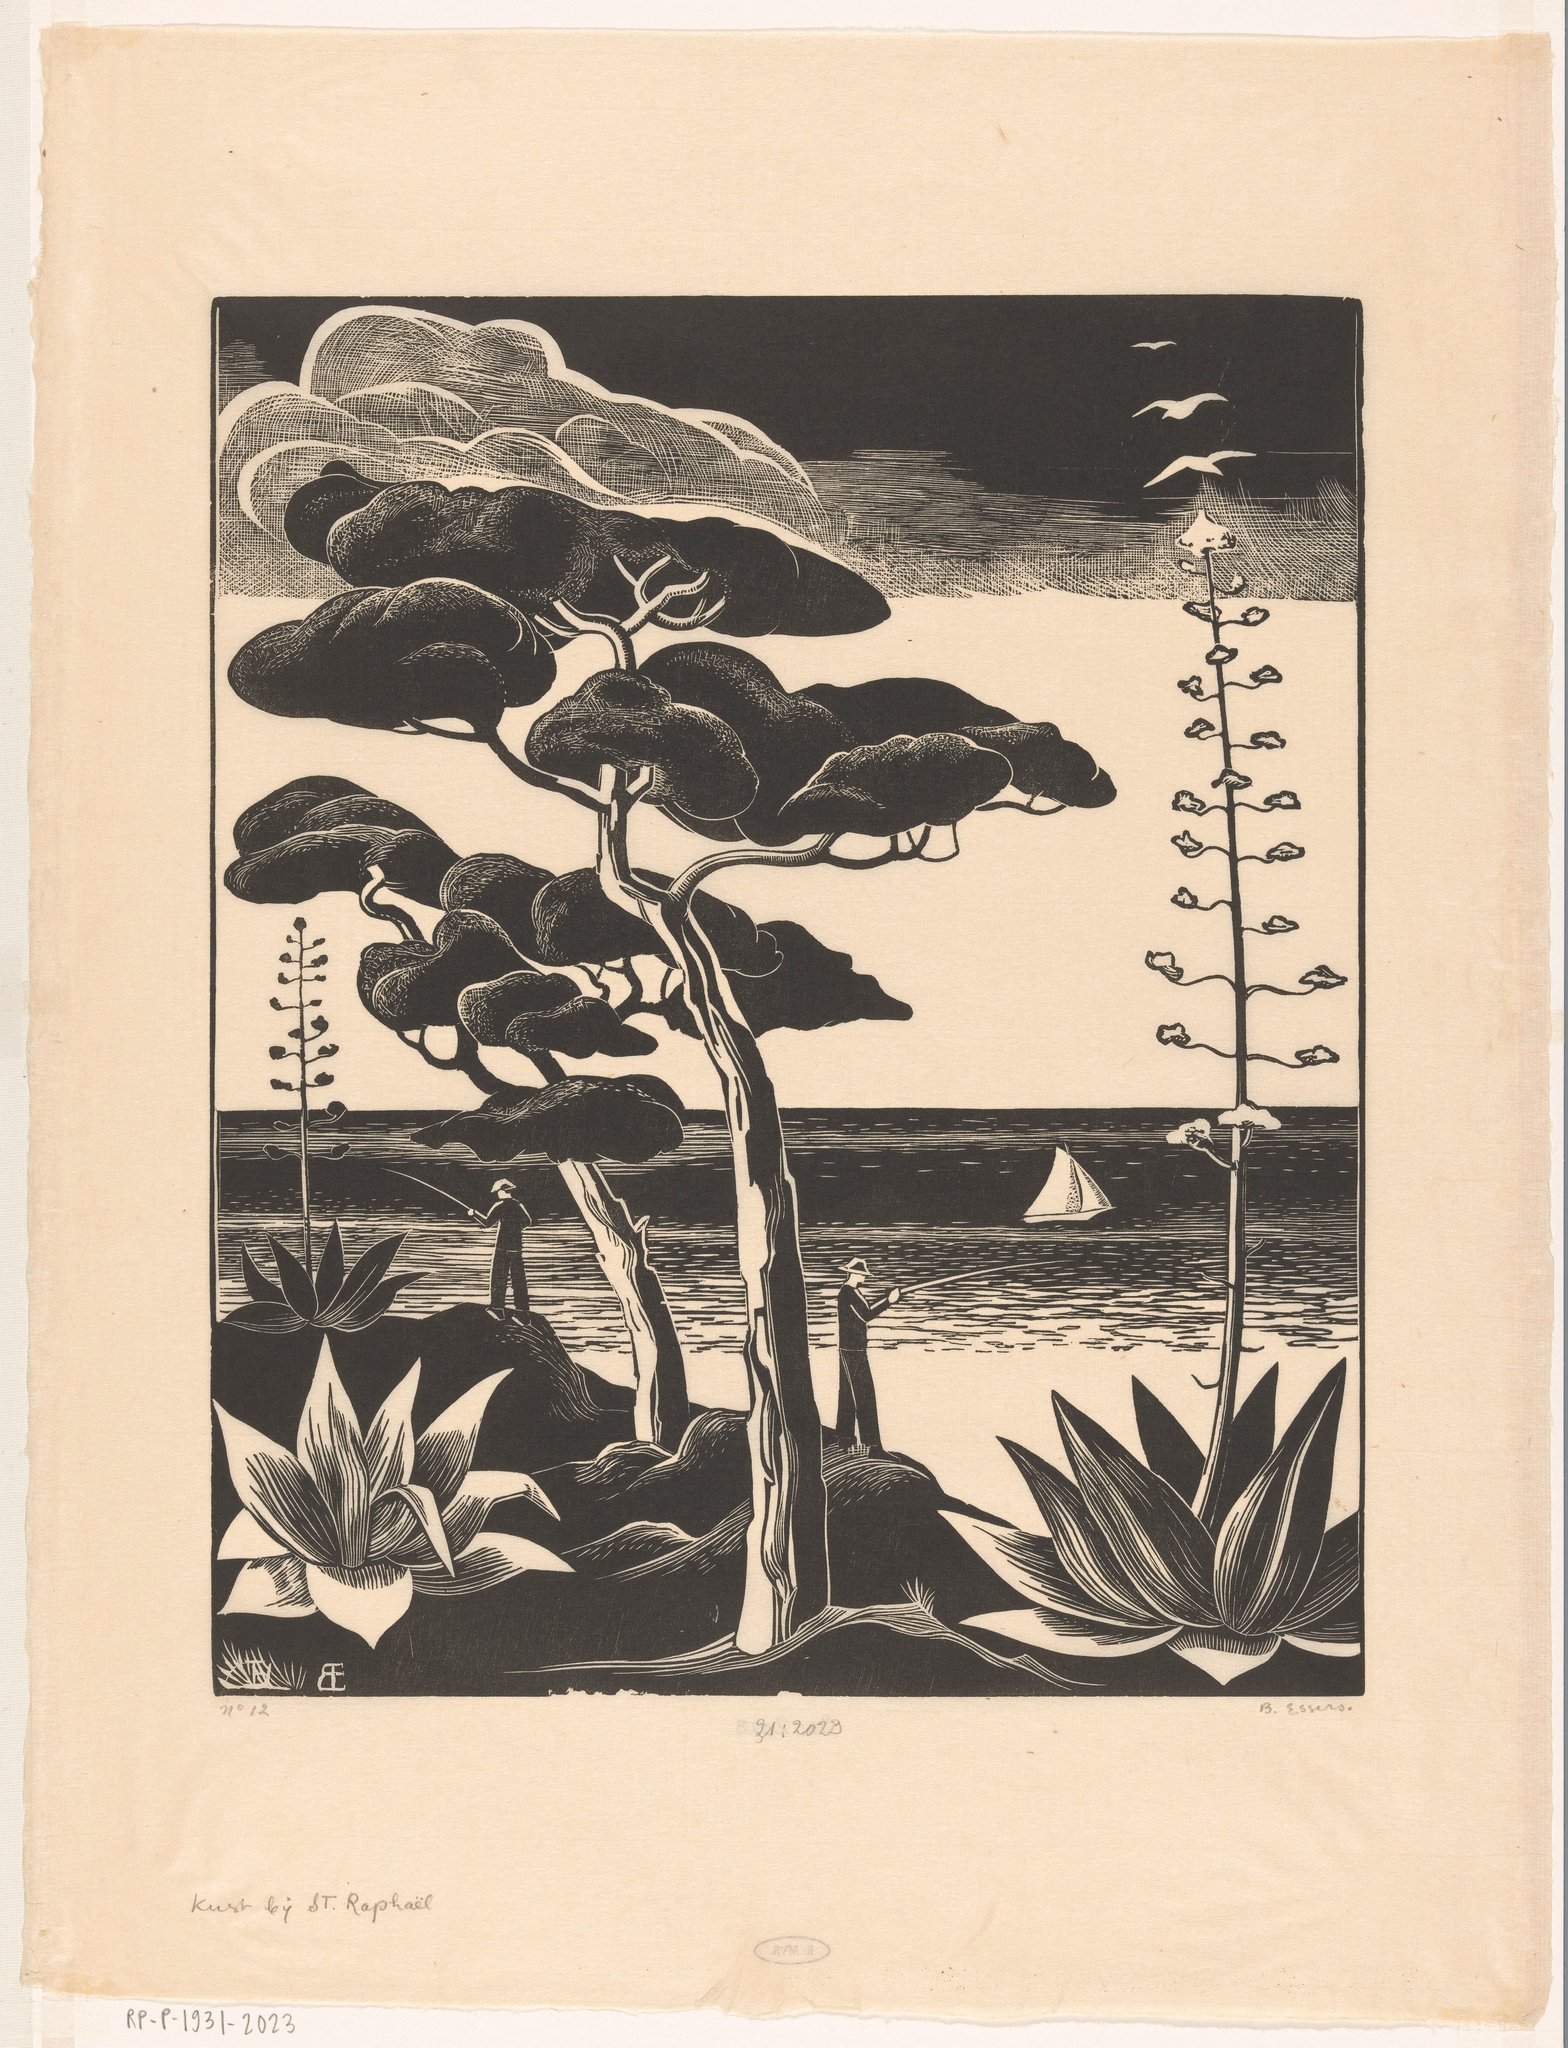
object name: print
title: Kust bij Saint-Raphaël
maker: bernard essers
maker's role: print maker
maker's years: 1893-1945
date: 1930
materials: paper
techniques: woodcut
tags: rocky coast, fishing (sports)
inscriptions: collector's mark: Lugt 2228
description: Twee vissers tussen begroeiing op rotsen aan zee nabij Saint-Raphaël, een plaats ten westen van Cannes in Frankrijk.